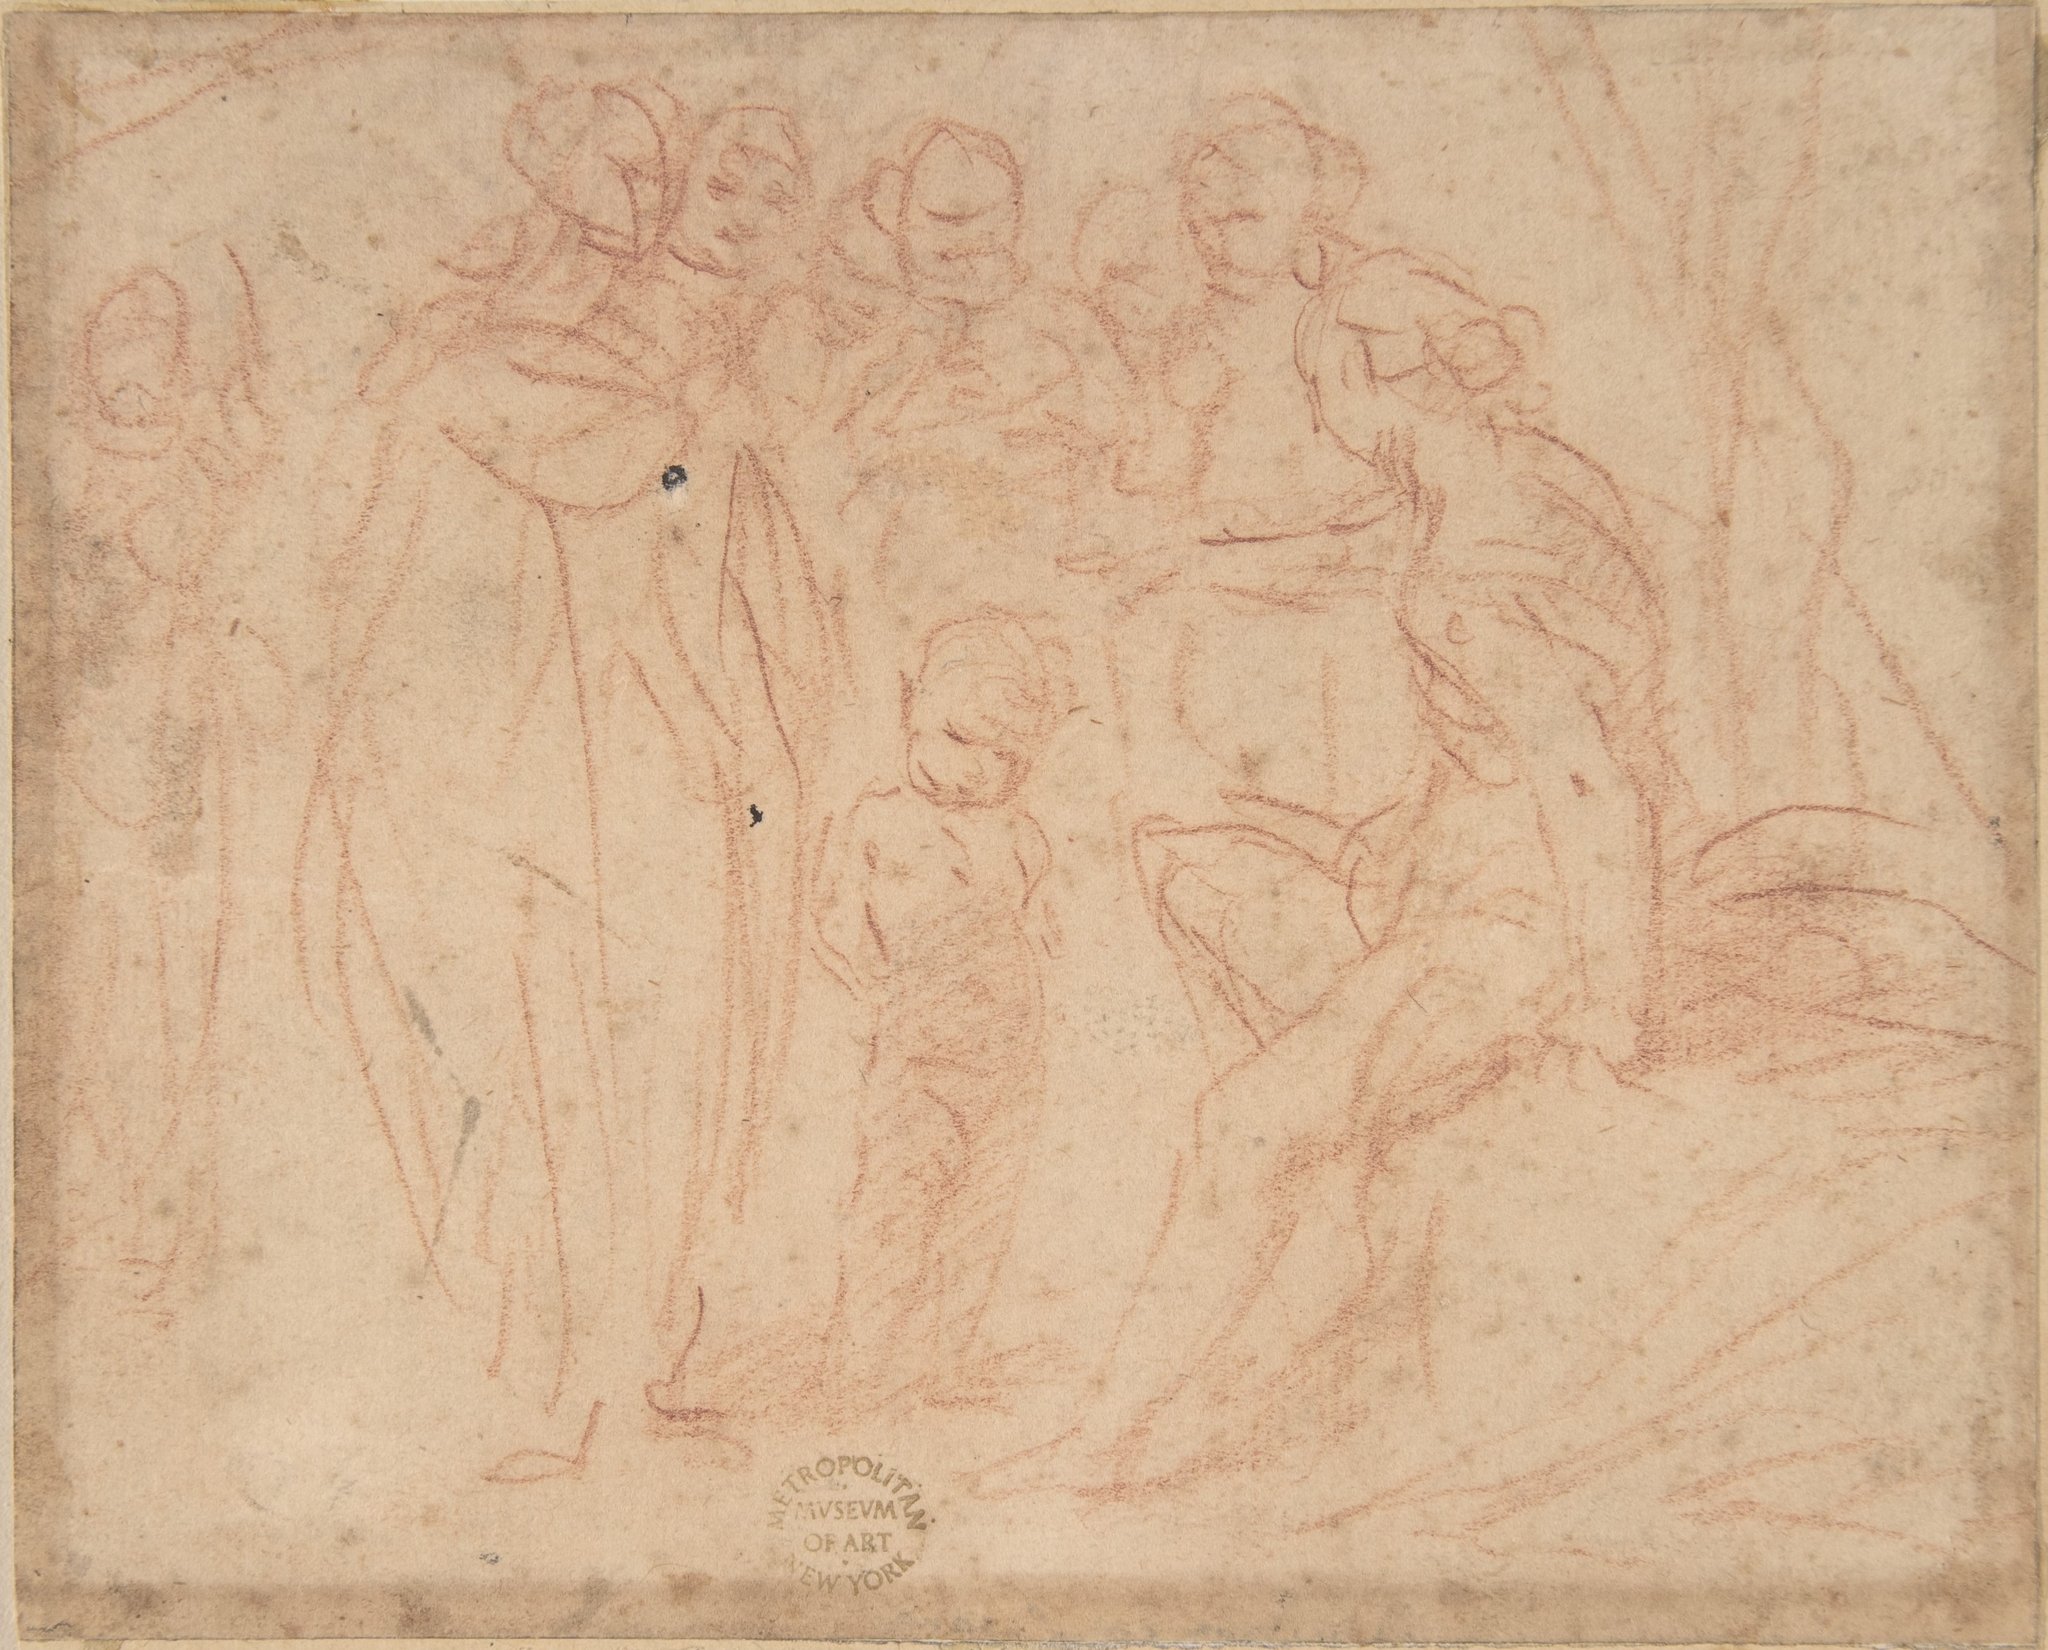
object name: drawing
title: Diana and Attendants?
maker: anonymous, italian, roman-bolognese, 17th century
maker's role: artist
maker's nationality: italian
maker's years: 1600-1700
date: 1601-1700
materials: chalk, paper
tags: children,women,diana